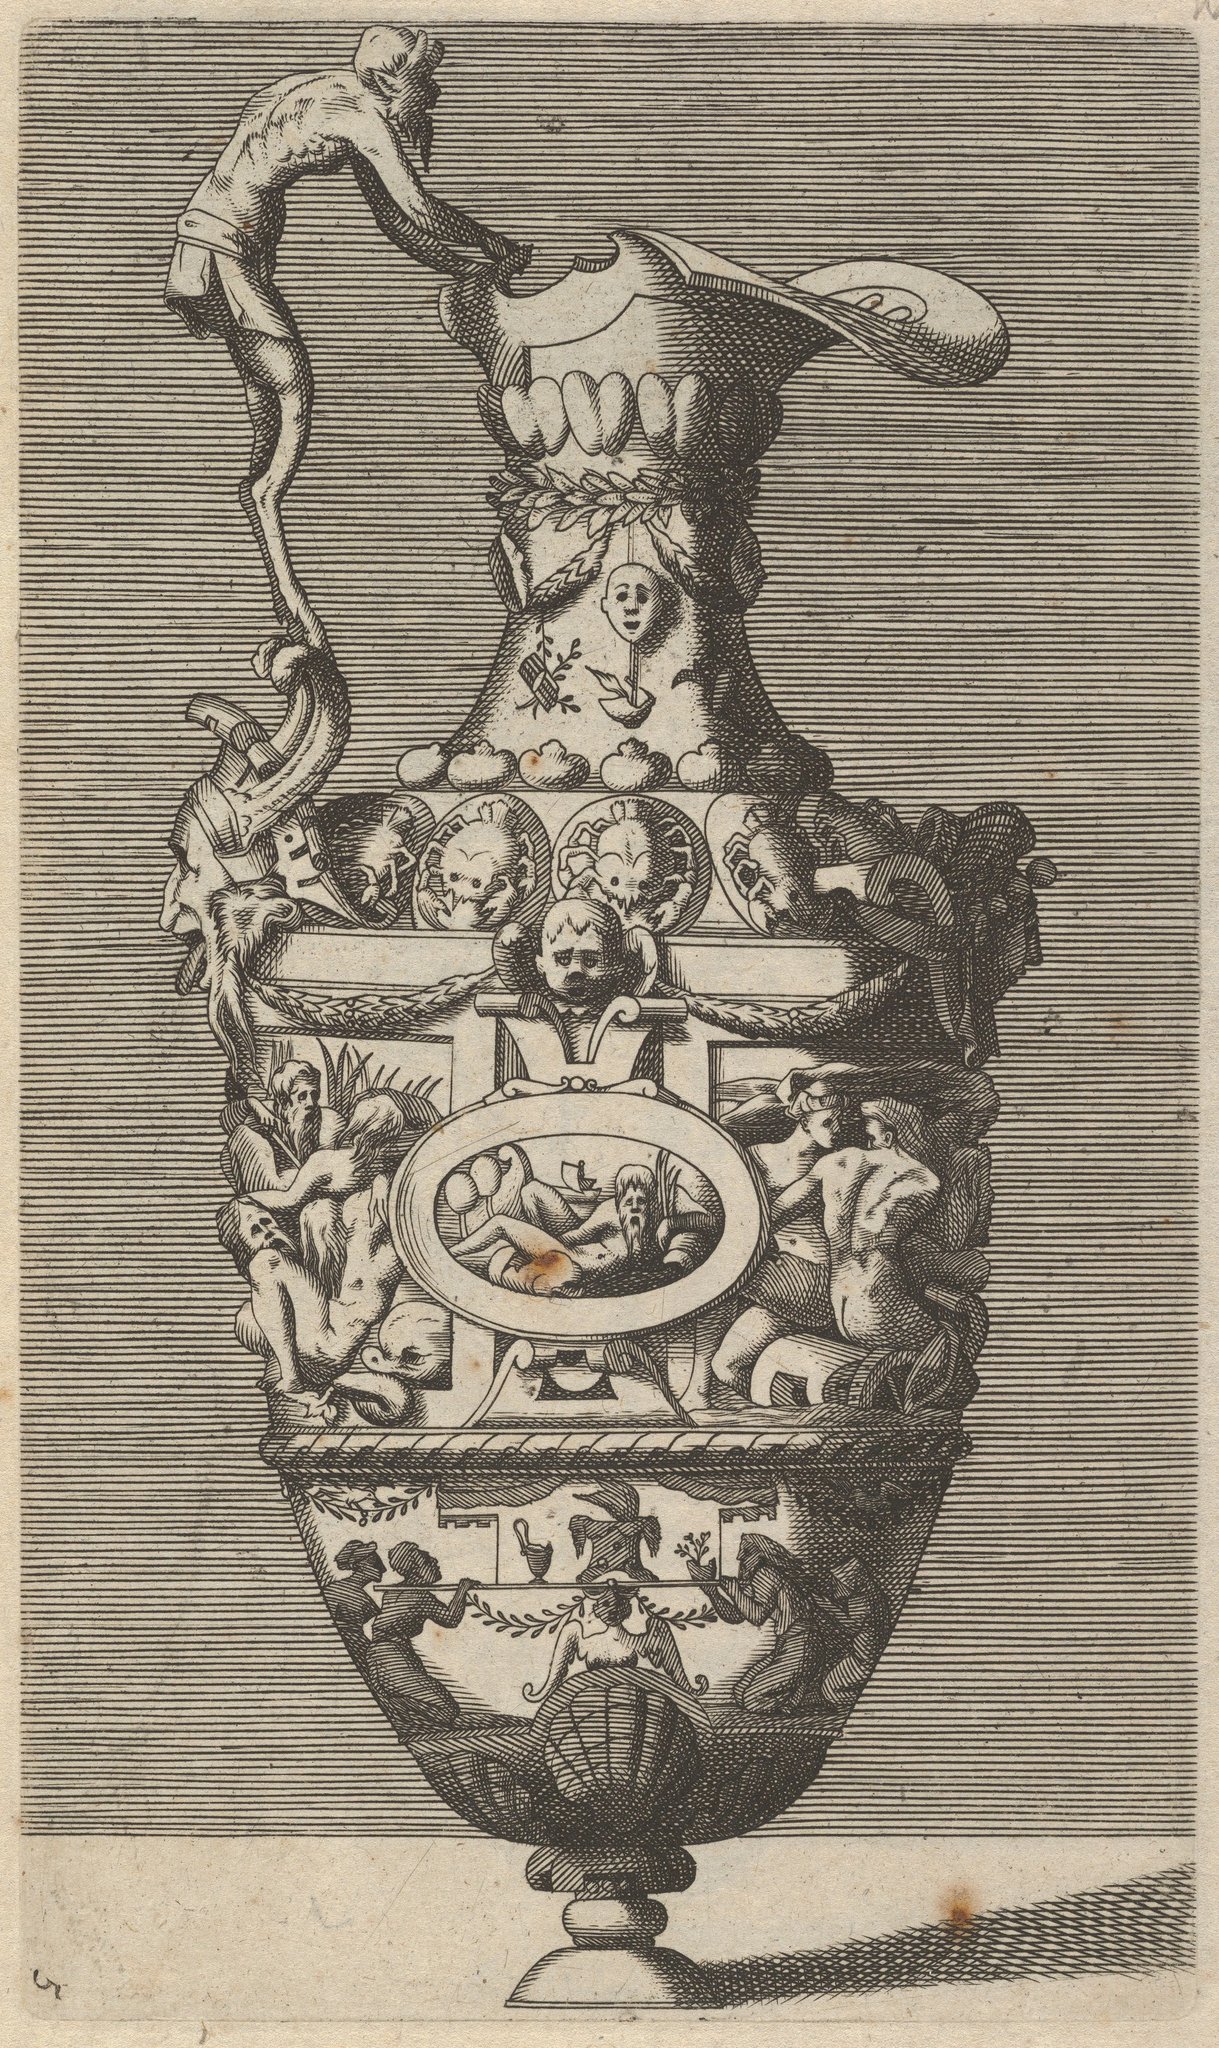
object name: print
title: Vase with a River God in an Oval Medallion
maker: rené boyvin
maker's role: artist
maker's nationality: french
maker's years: 1525-1598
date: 1601-1700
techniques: engraving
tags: vases